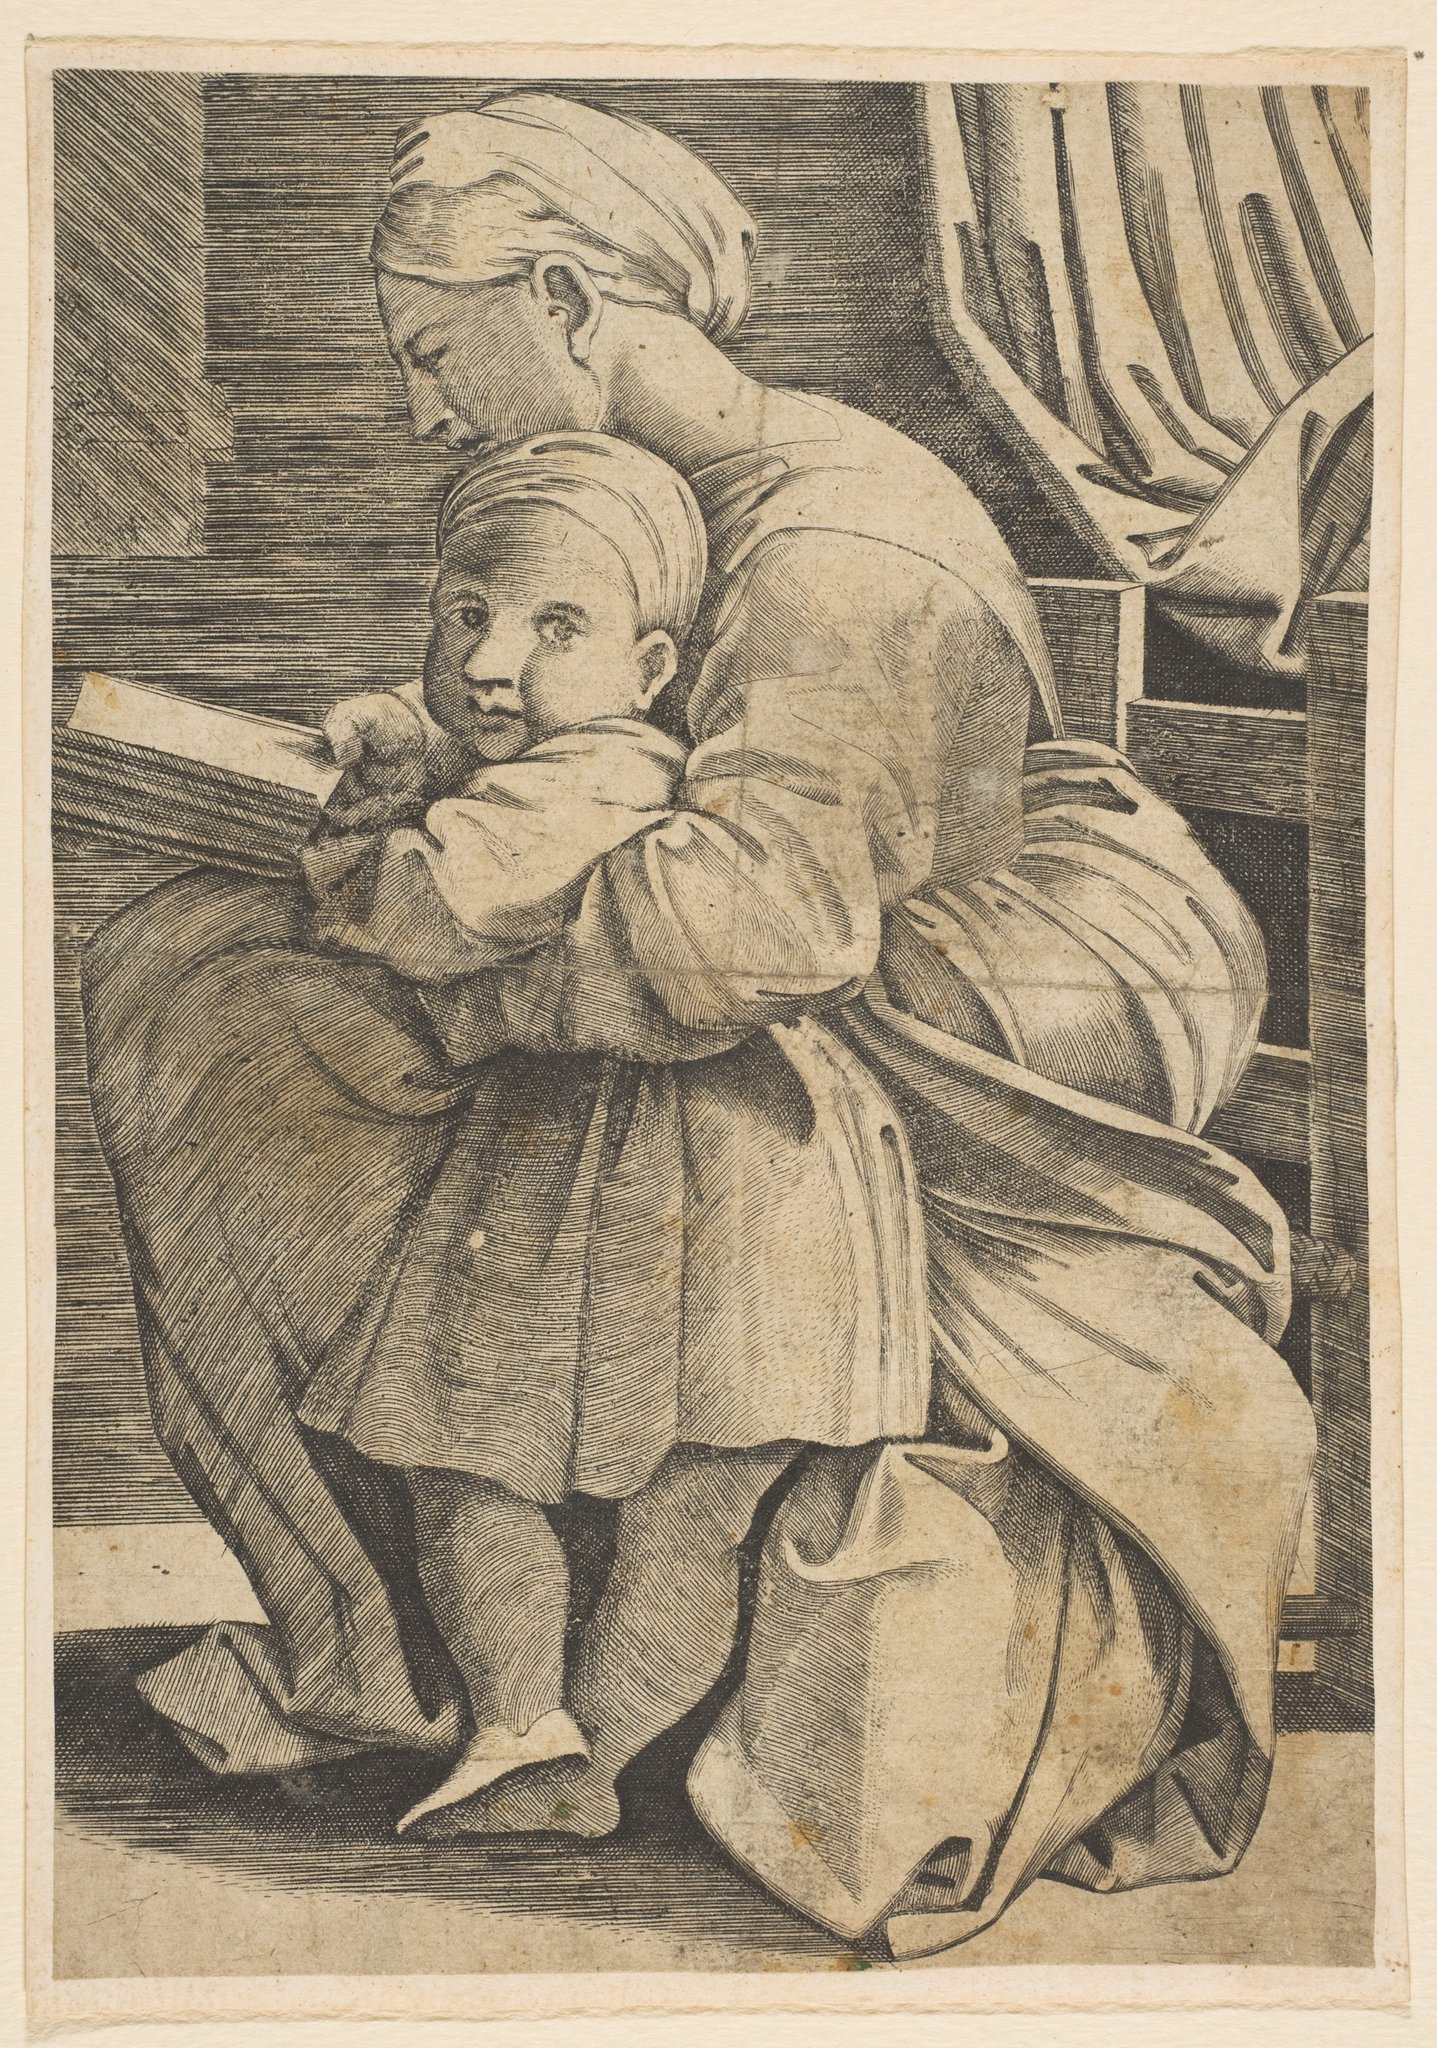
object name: print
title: The Virgin reading with the infant Christ; woman seated in profile facing left and reading with an arm around a child who looks out toward the viewer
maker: anonymous, italian, 16th to early 17th century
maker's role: artist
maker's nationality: italian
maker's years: 1500-1640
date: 1515-1600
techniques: engraving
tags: reading,madonna and child